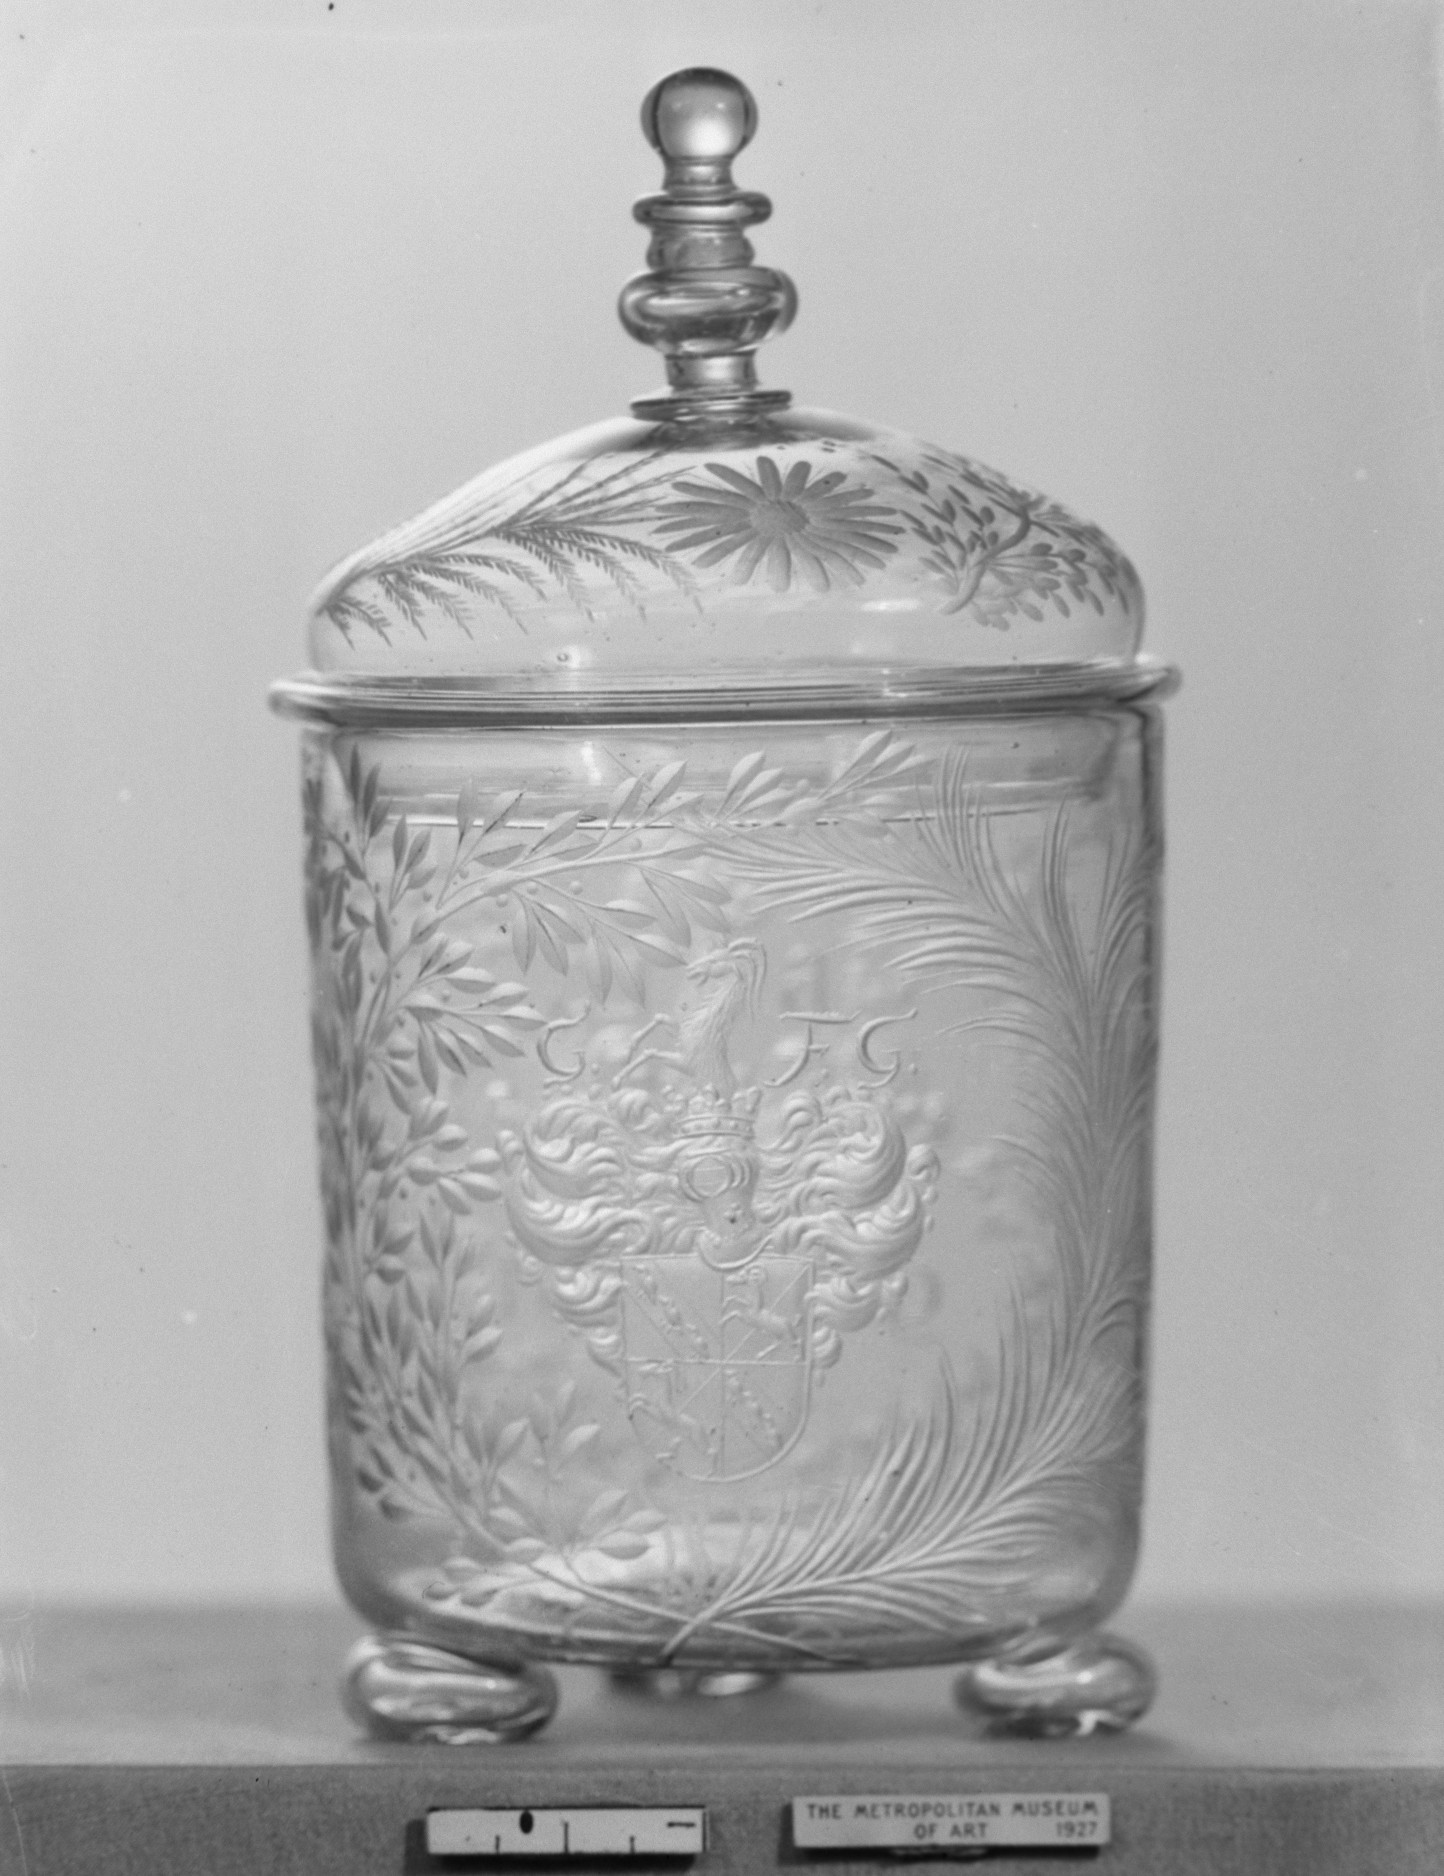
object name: beaker with cover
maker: hermann schwinger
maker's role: maker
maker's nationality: german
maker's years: 1640-1683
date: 1665-1674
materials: glass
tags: coat of arms